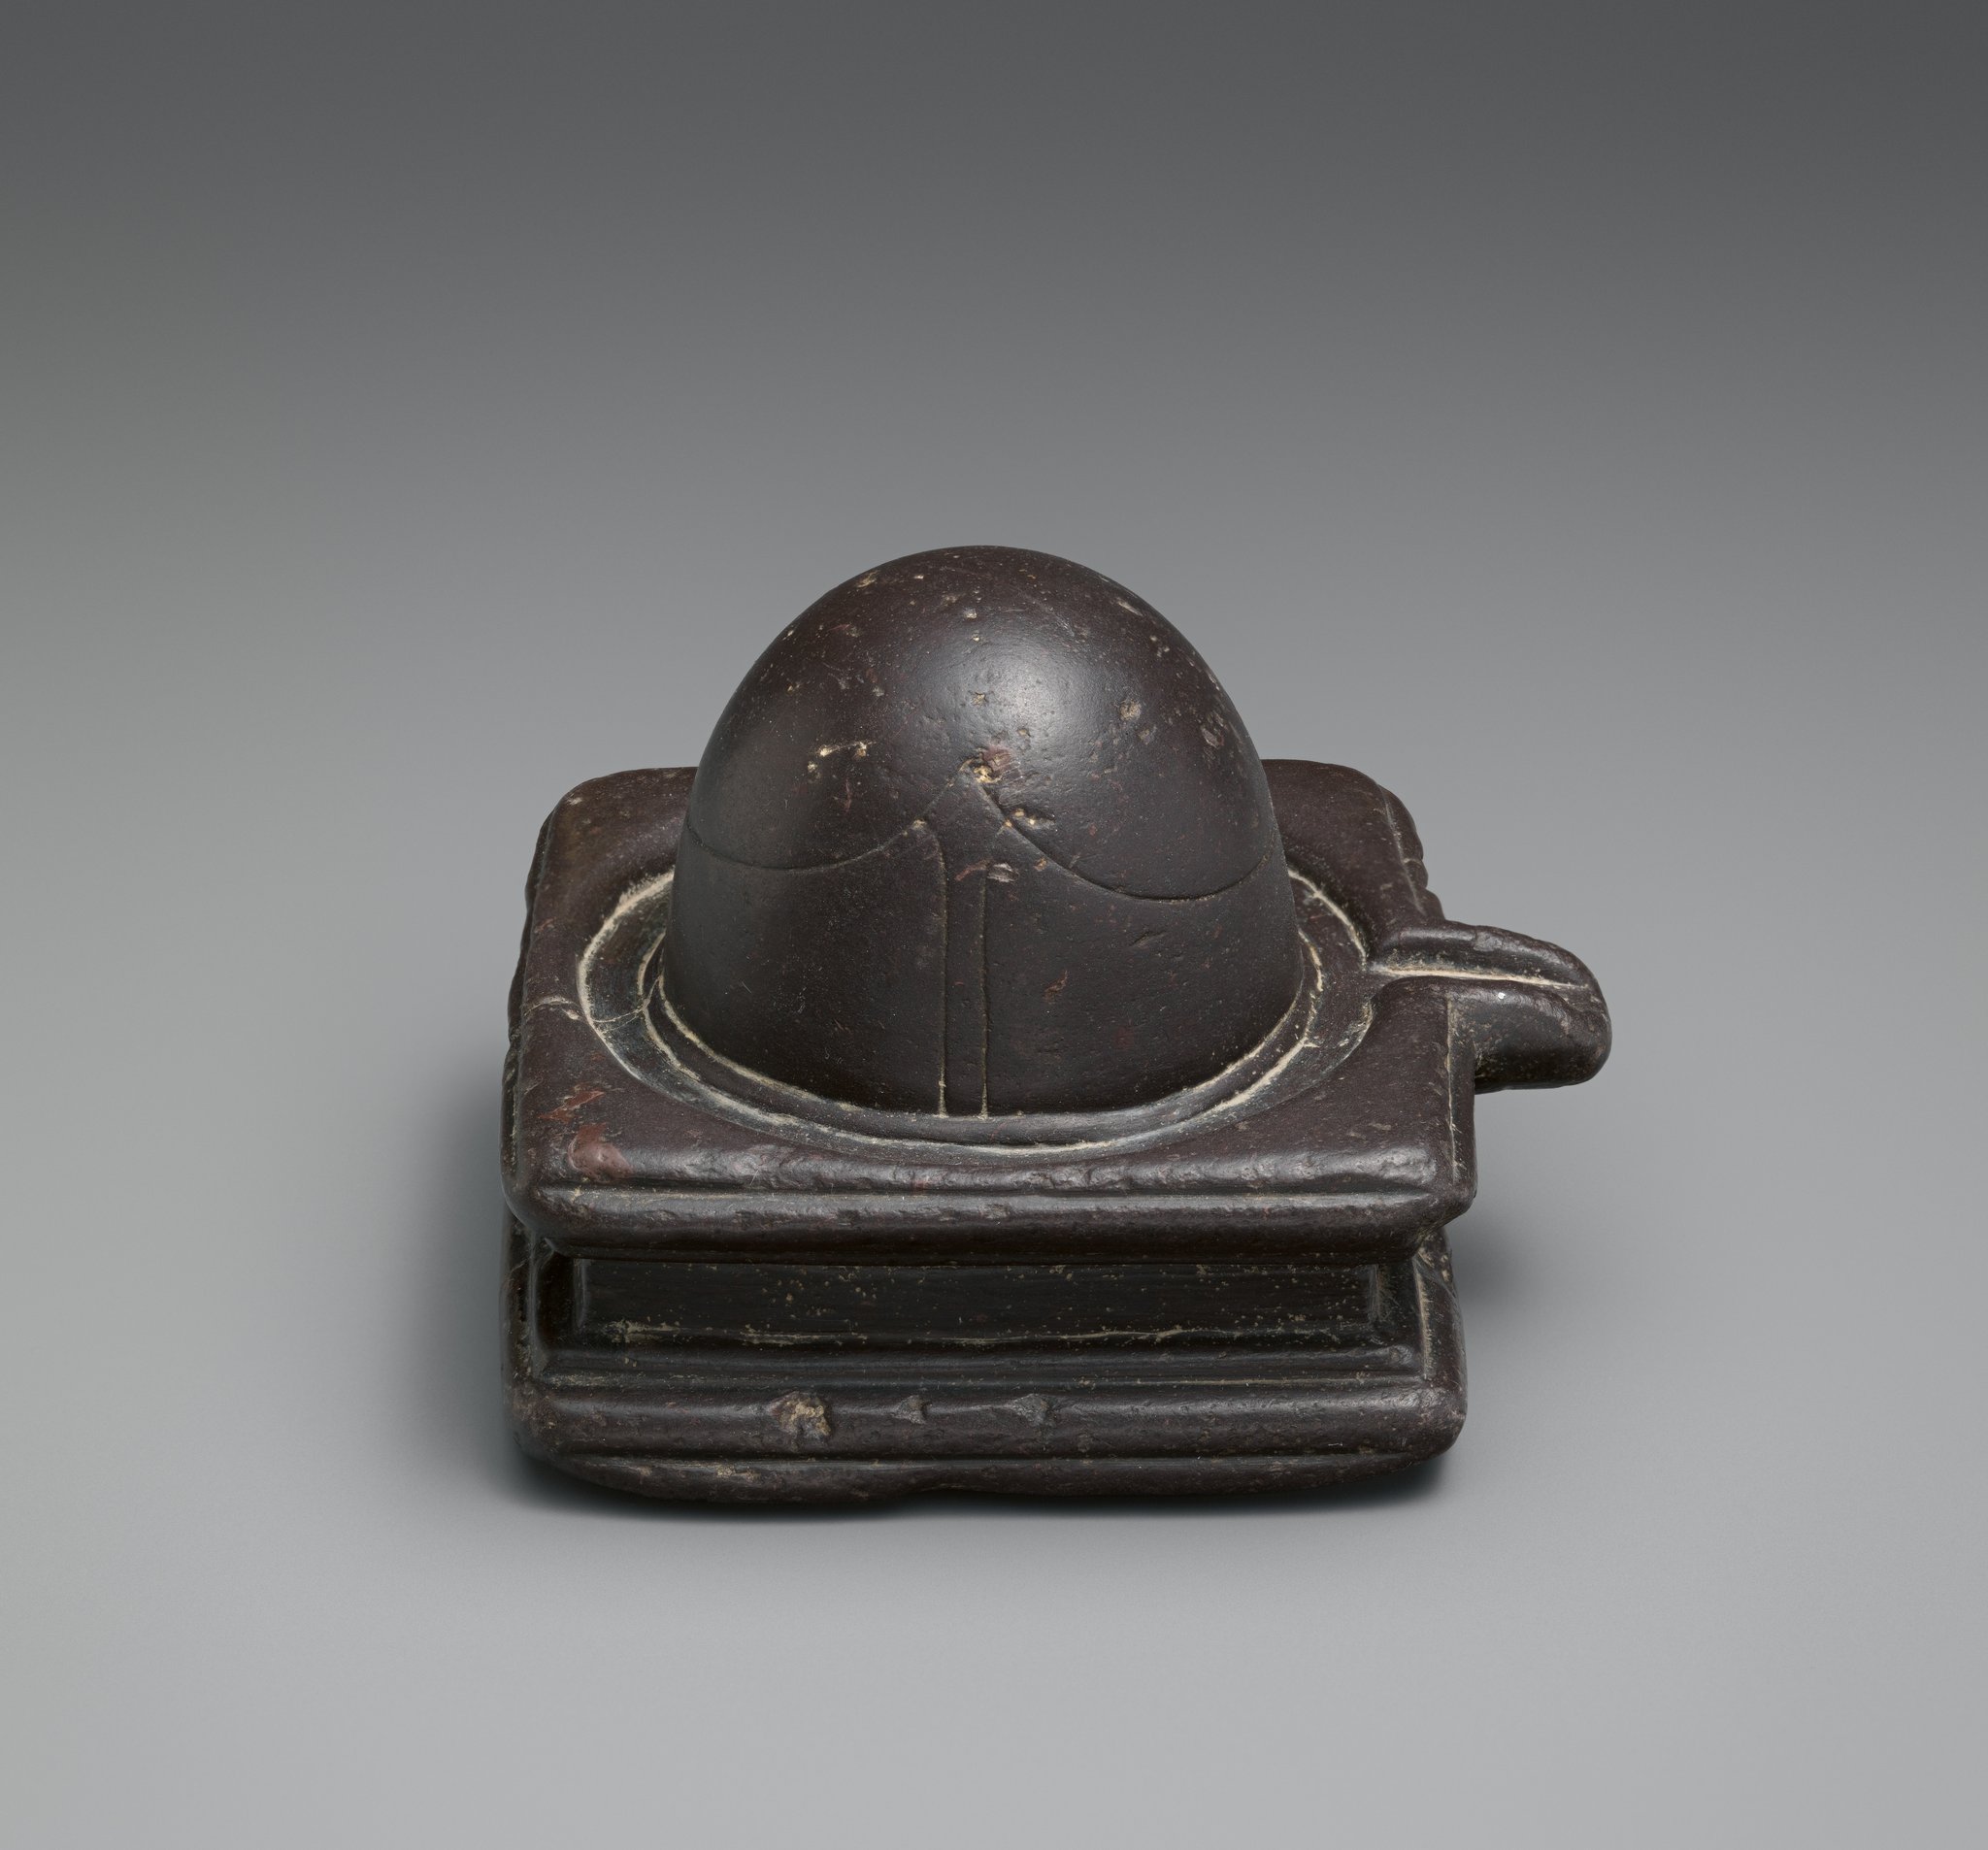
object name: linga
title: Linga, Shiva’s Aniconic Symbol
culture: kashmiri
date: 701-800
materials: stone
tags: kashmir